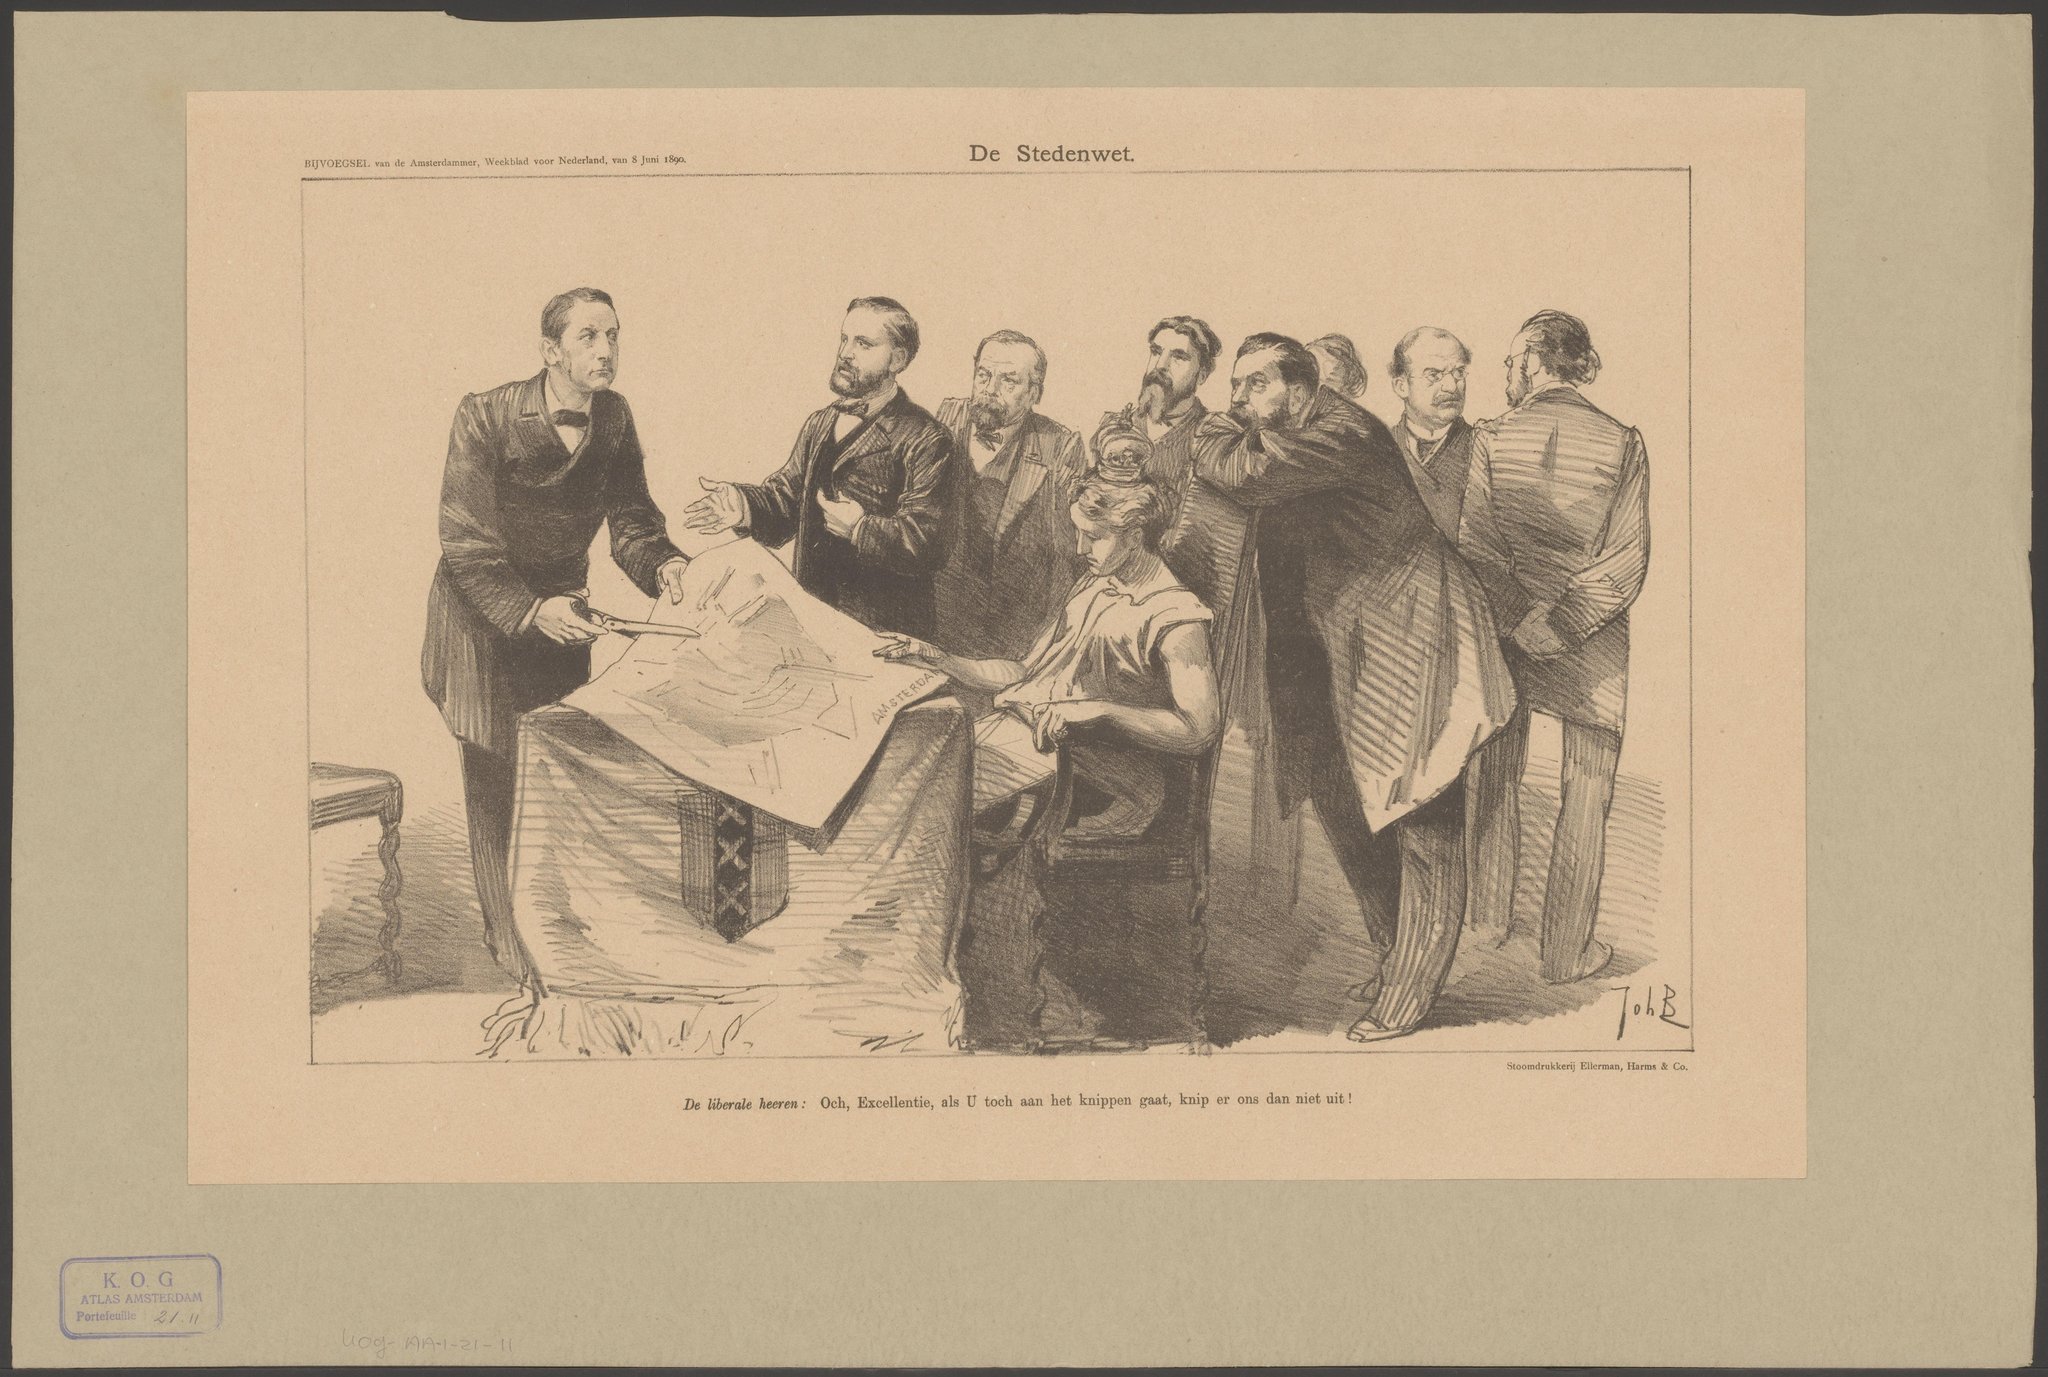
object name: cartoon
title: De Stedenwet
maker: johan braakensiek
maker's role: draughtsman, print maker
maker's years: 1858-1940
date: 1890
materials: paper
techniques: letterpress printing, lithograph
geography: netherlands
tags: the hague, jonkheer alexander frederik de savornin lohman, personification of a city, town-patron(ess), politician, e.g. party leader, tools, aids, implements ~ crafts and industries: scissors, maps of cities, political caricatures and satires, amsterdam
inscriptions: collector's mark: Lugt 1641b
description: Minister van Binnenlandse Zaken Alexander Frederik de Savornin Lohman zet de schaar in een plattegrond van Amsterdam die op een tafel ligt voor de Amsterdamse stedenmaagd. Naast en achter haar meerdere liberale politici. Onderwerpsrubriek binnen de Atlas Amsterdam: Kiesverenigingen, Politieke partijen.